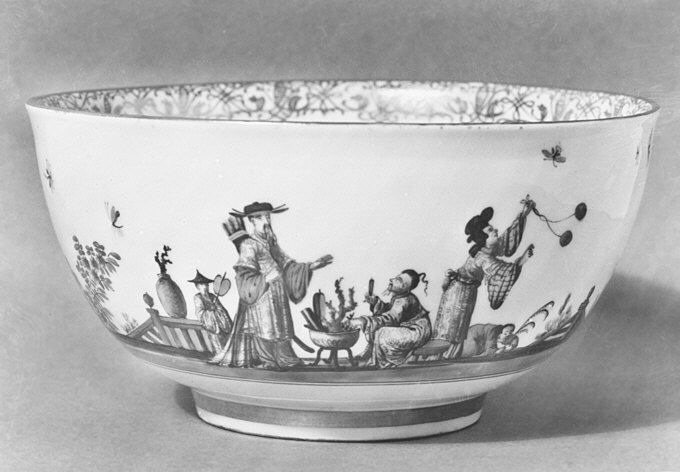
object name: bowl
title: Bowl (part of a set)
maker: meissen manufactory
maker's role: manufactory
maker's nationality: german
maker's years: 1710-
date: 1735-1740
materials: hard paste porcelain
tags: men,women